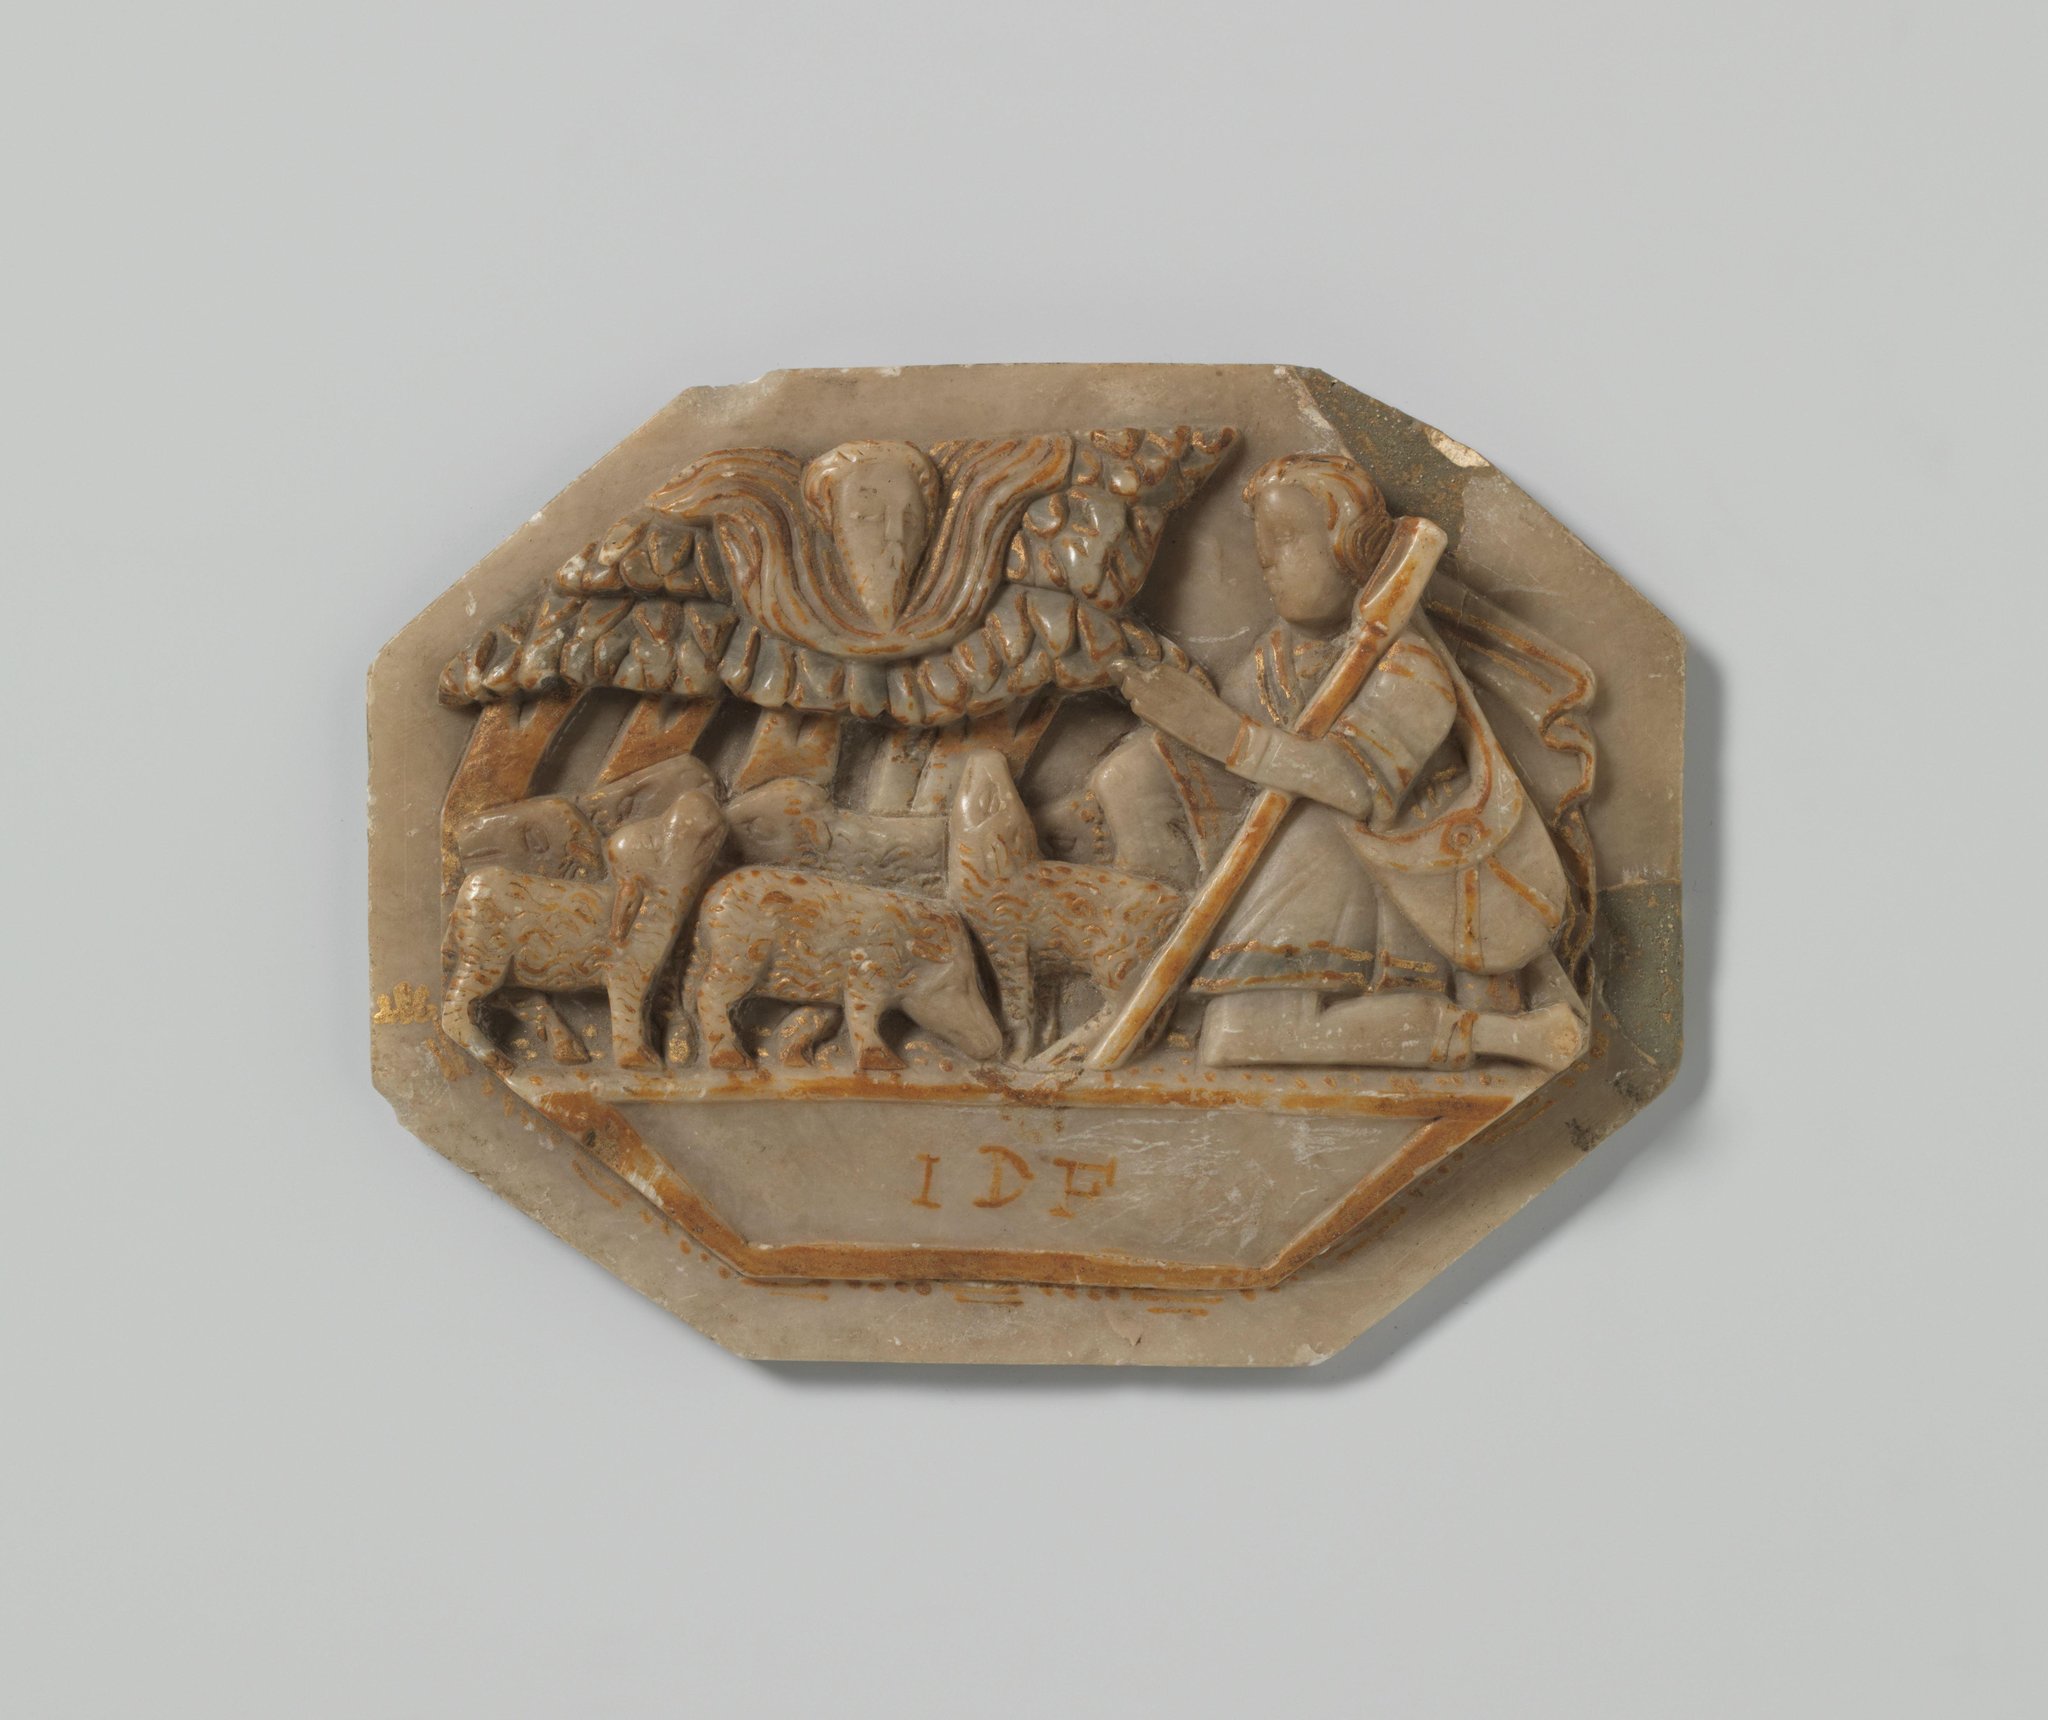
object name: relief sculpture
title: Reliëf, achtkantig, met religieuze afbeelding. Bestaat uit 2 delen.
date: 1400-1950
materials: marble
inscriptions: mark: ‘IDP’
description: Mozes en de brandende braambos. Resten van goudverf nog zichtbaar.